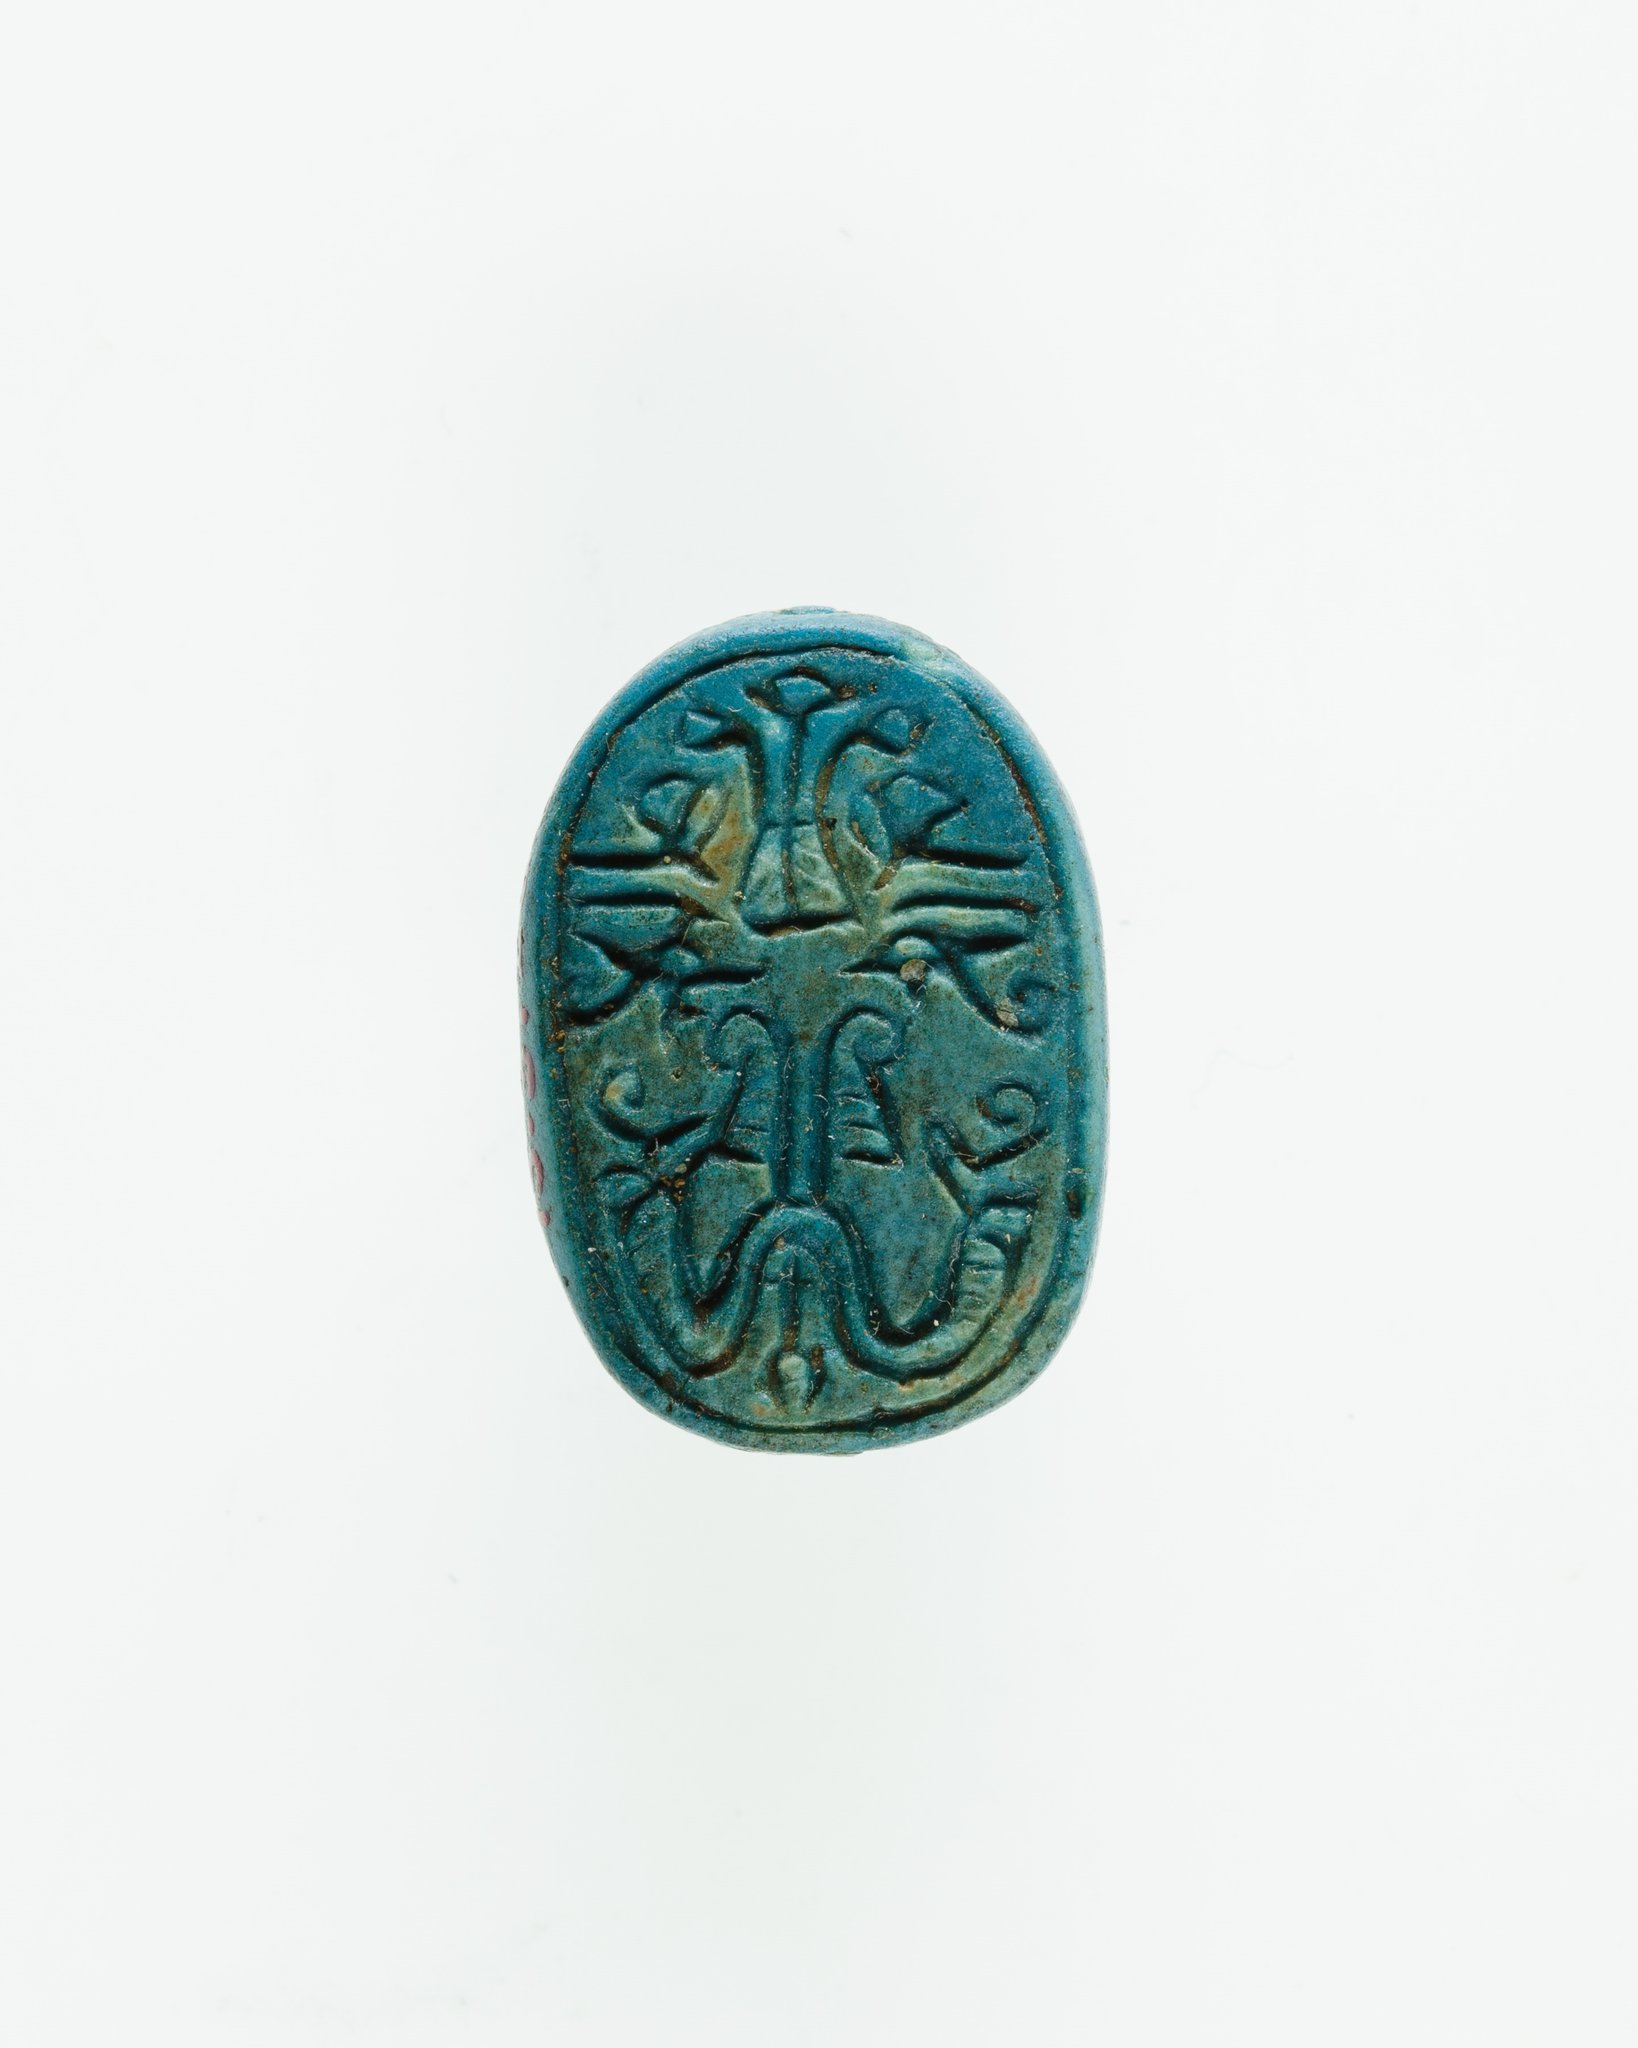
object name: scarab, hieroglyph, papyrus, uraei, wedjat, hat lion forepart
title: Scarab Inscribed with Hieroglyphs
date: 1850-1640 BCE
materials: faience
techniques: glazing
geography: egypt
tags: hieroglyphs